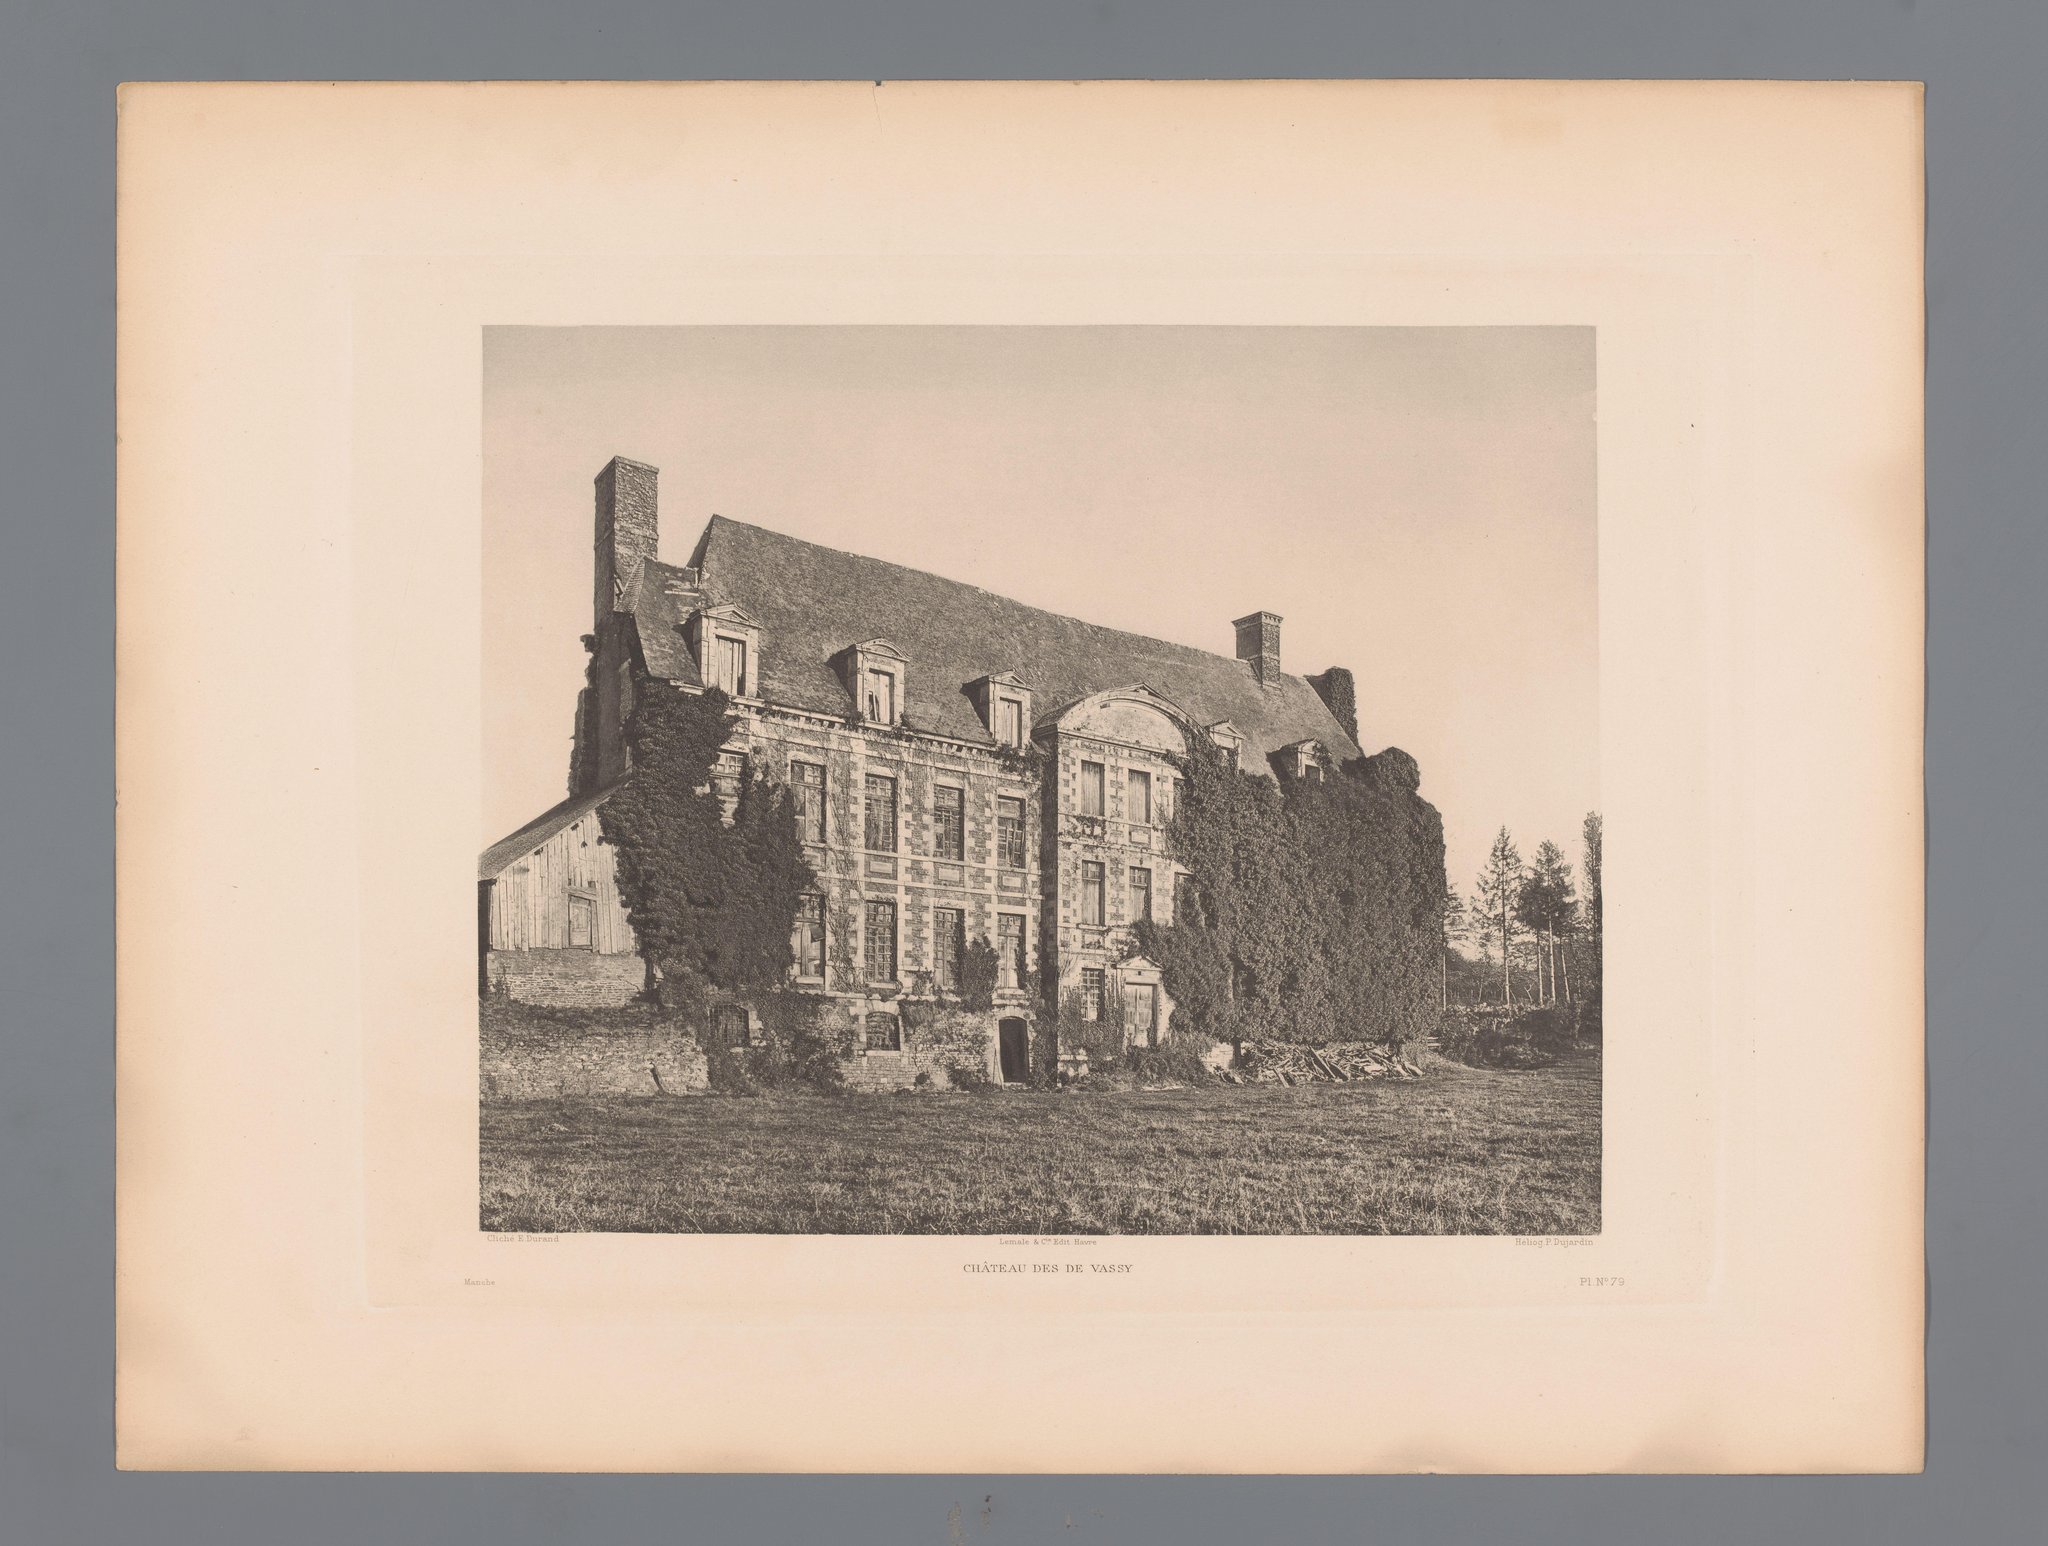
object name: photomechanical print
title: Gezicht op Château de Vassy in Étaule, Frankrijk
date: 1890-1895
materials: paper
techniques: photoaquatint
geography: étaule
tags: castle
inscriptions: number: ‘Pl. No. 79’, inscription: ‘Manche’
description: Deze prent maakt deel uit van een omslag met 12 prenten en 46 tekstbladen.